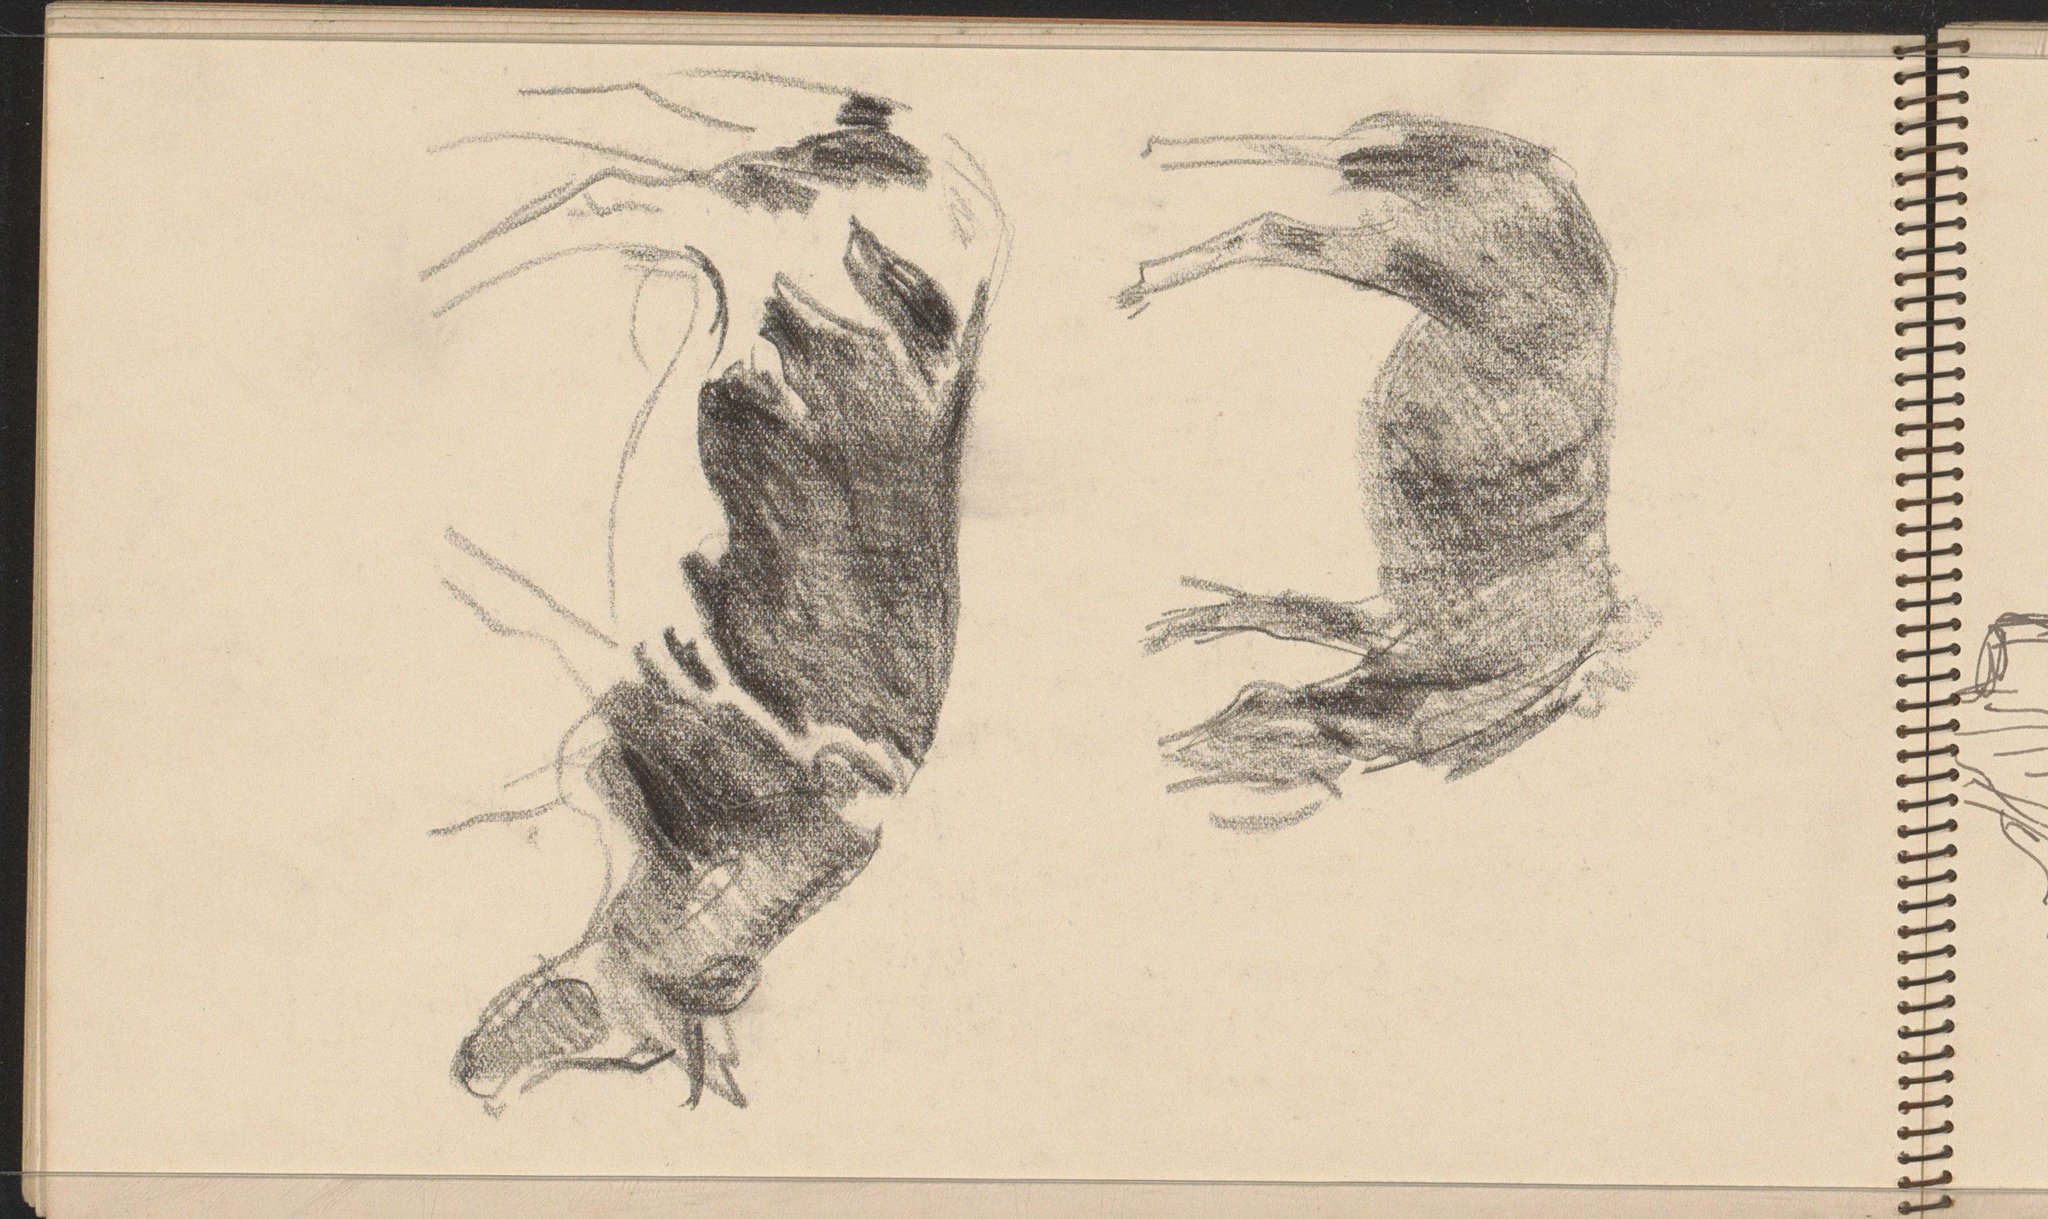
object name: sketchbook leaf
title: Paard en een koe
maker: carel adolph lion cachet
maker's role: draughtsman, print maker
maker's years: 1864-1945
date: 1930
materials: chalk, paper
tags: cow, horse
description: Blad 6 verso uit een schetsboek met 14 bladen.